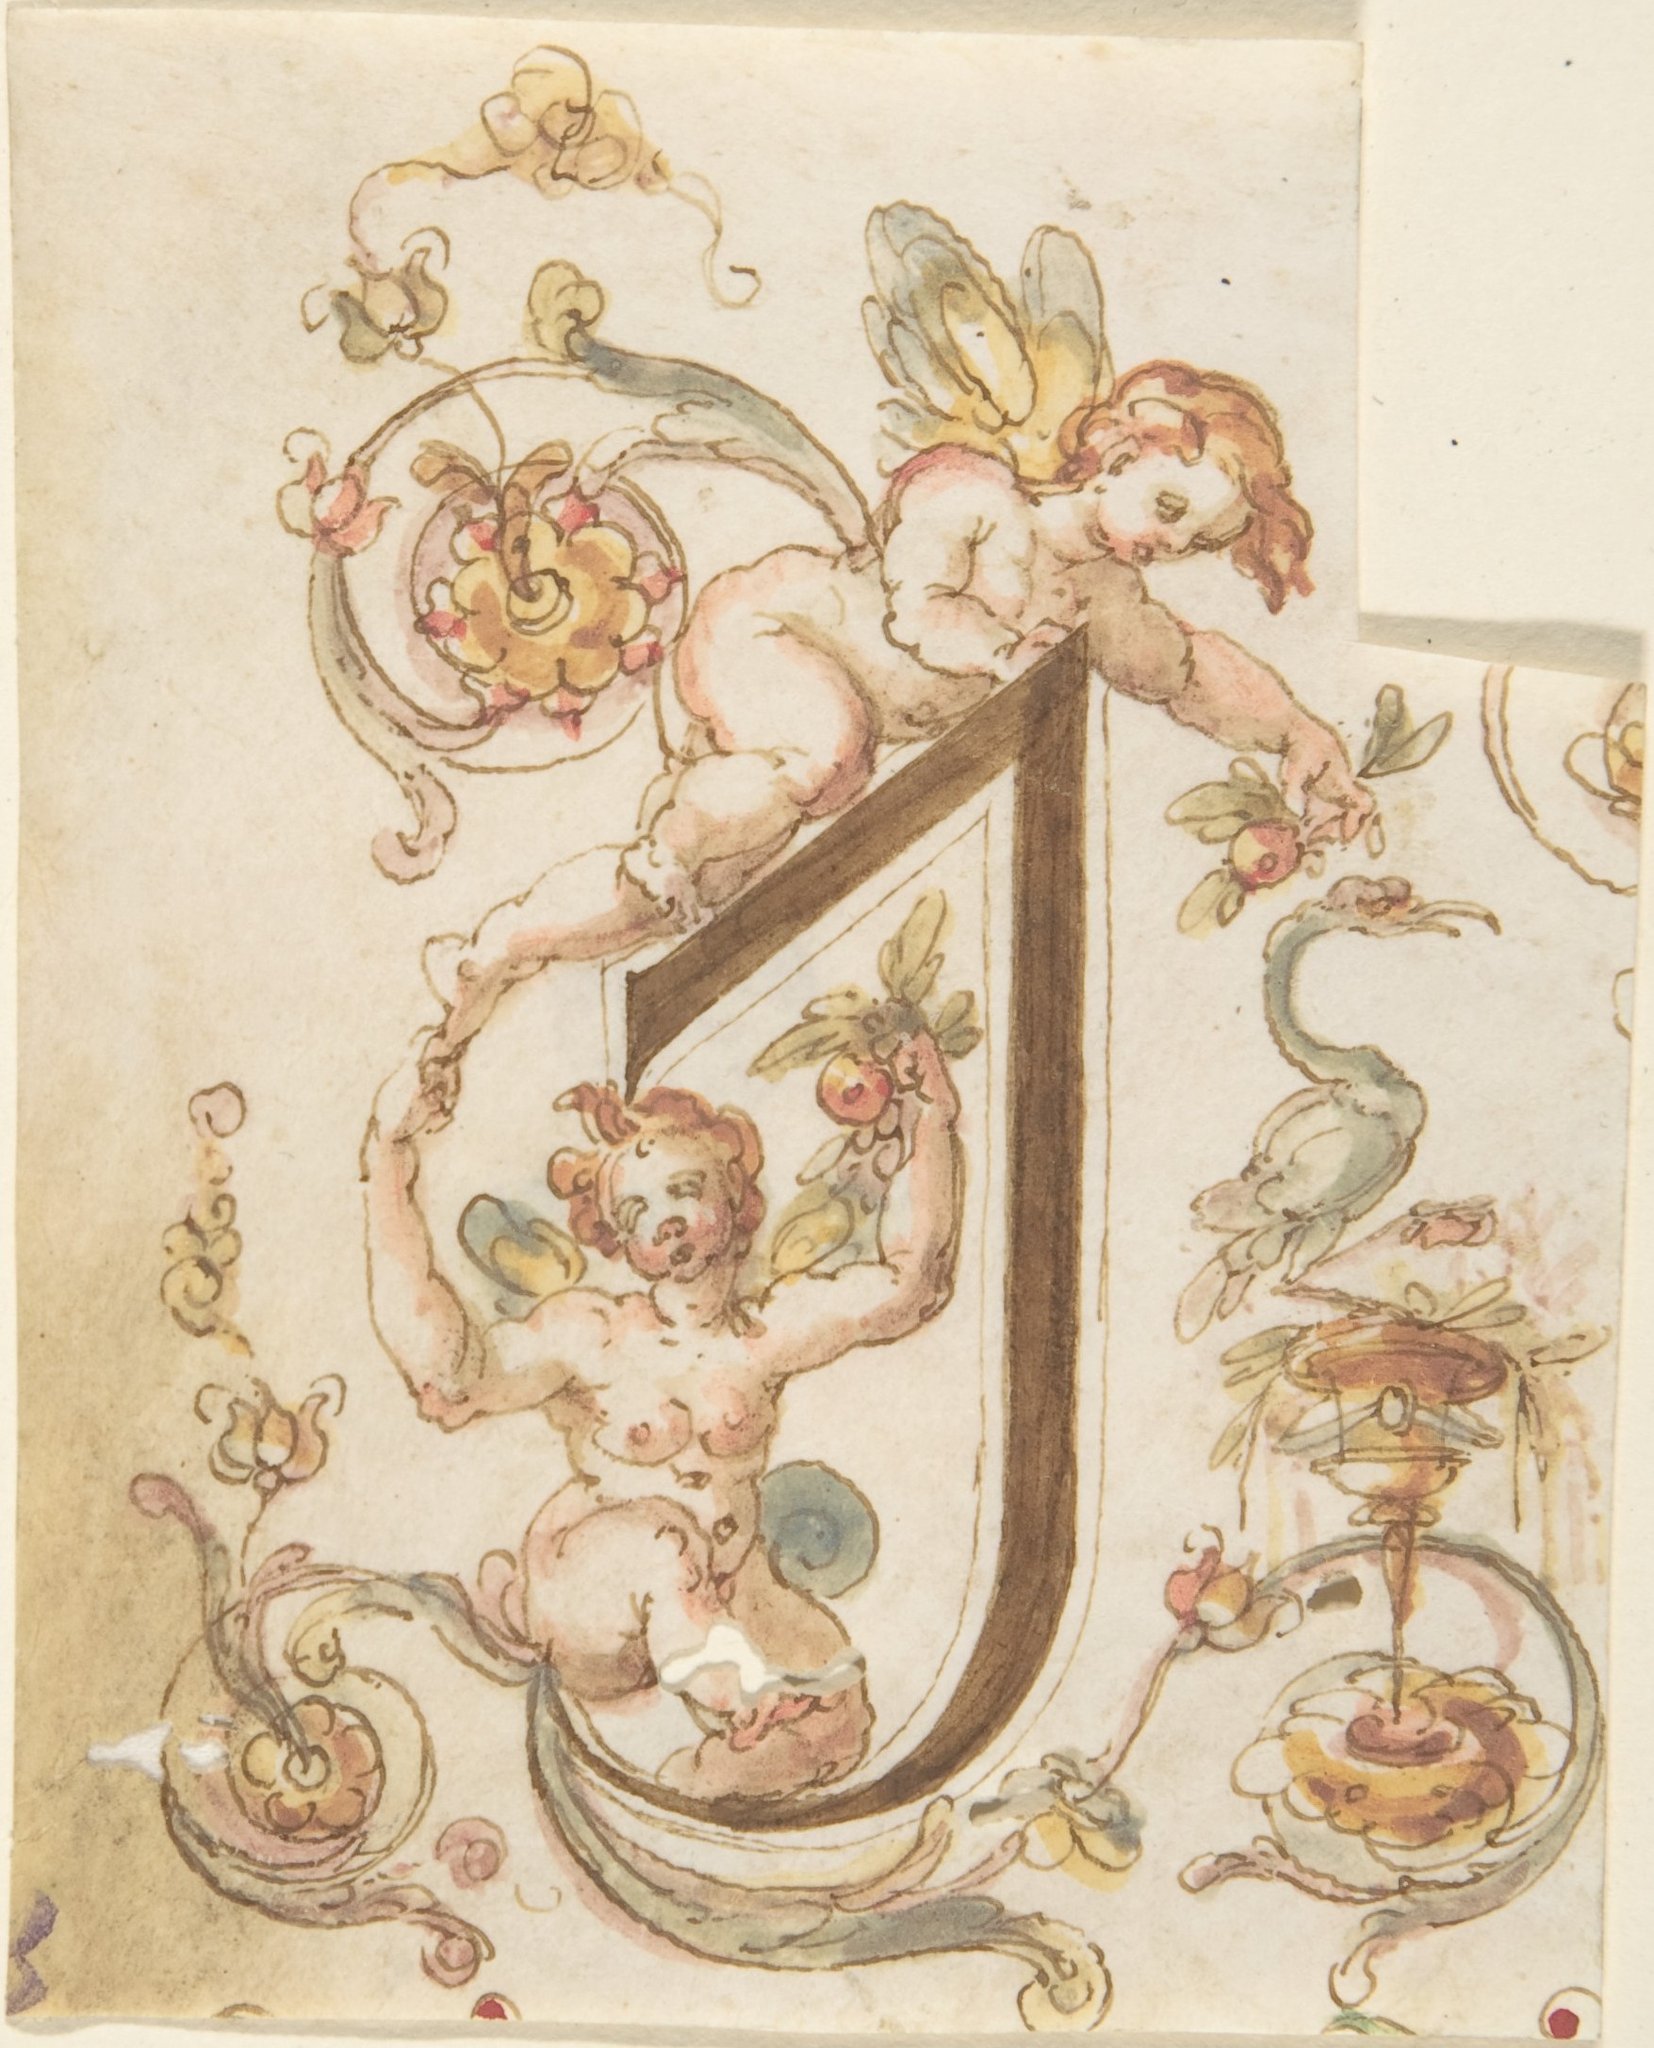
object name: drawing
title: Decorative Letter "I" with Putti (Embroidery Design?)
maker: anonymous, italian, 16th century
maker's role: artist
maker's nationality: italian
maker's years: 1500-1600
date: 1501-1600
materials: ink, parchment, watercolor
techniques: pen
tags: birds,ornament,putti